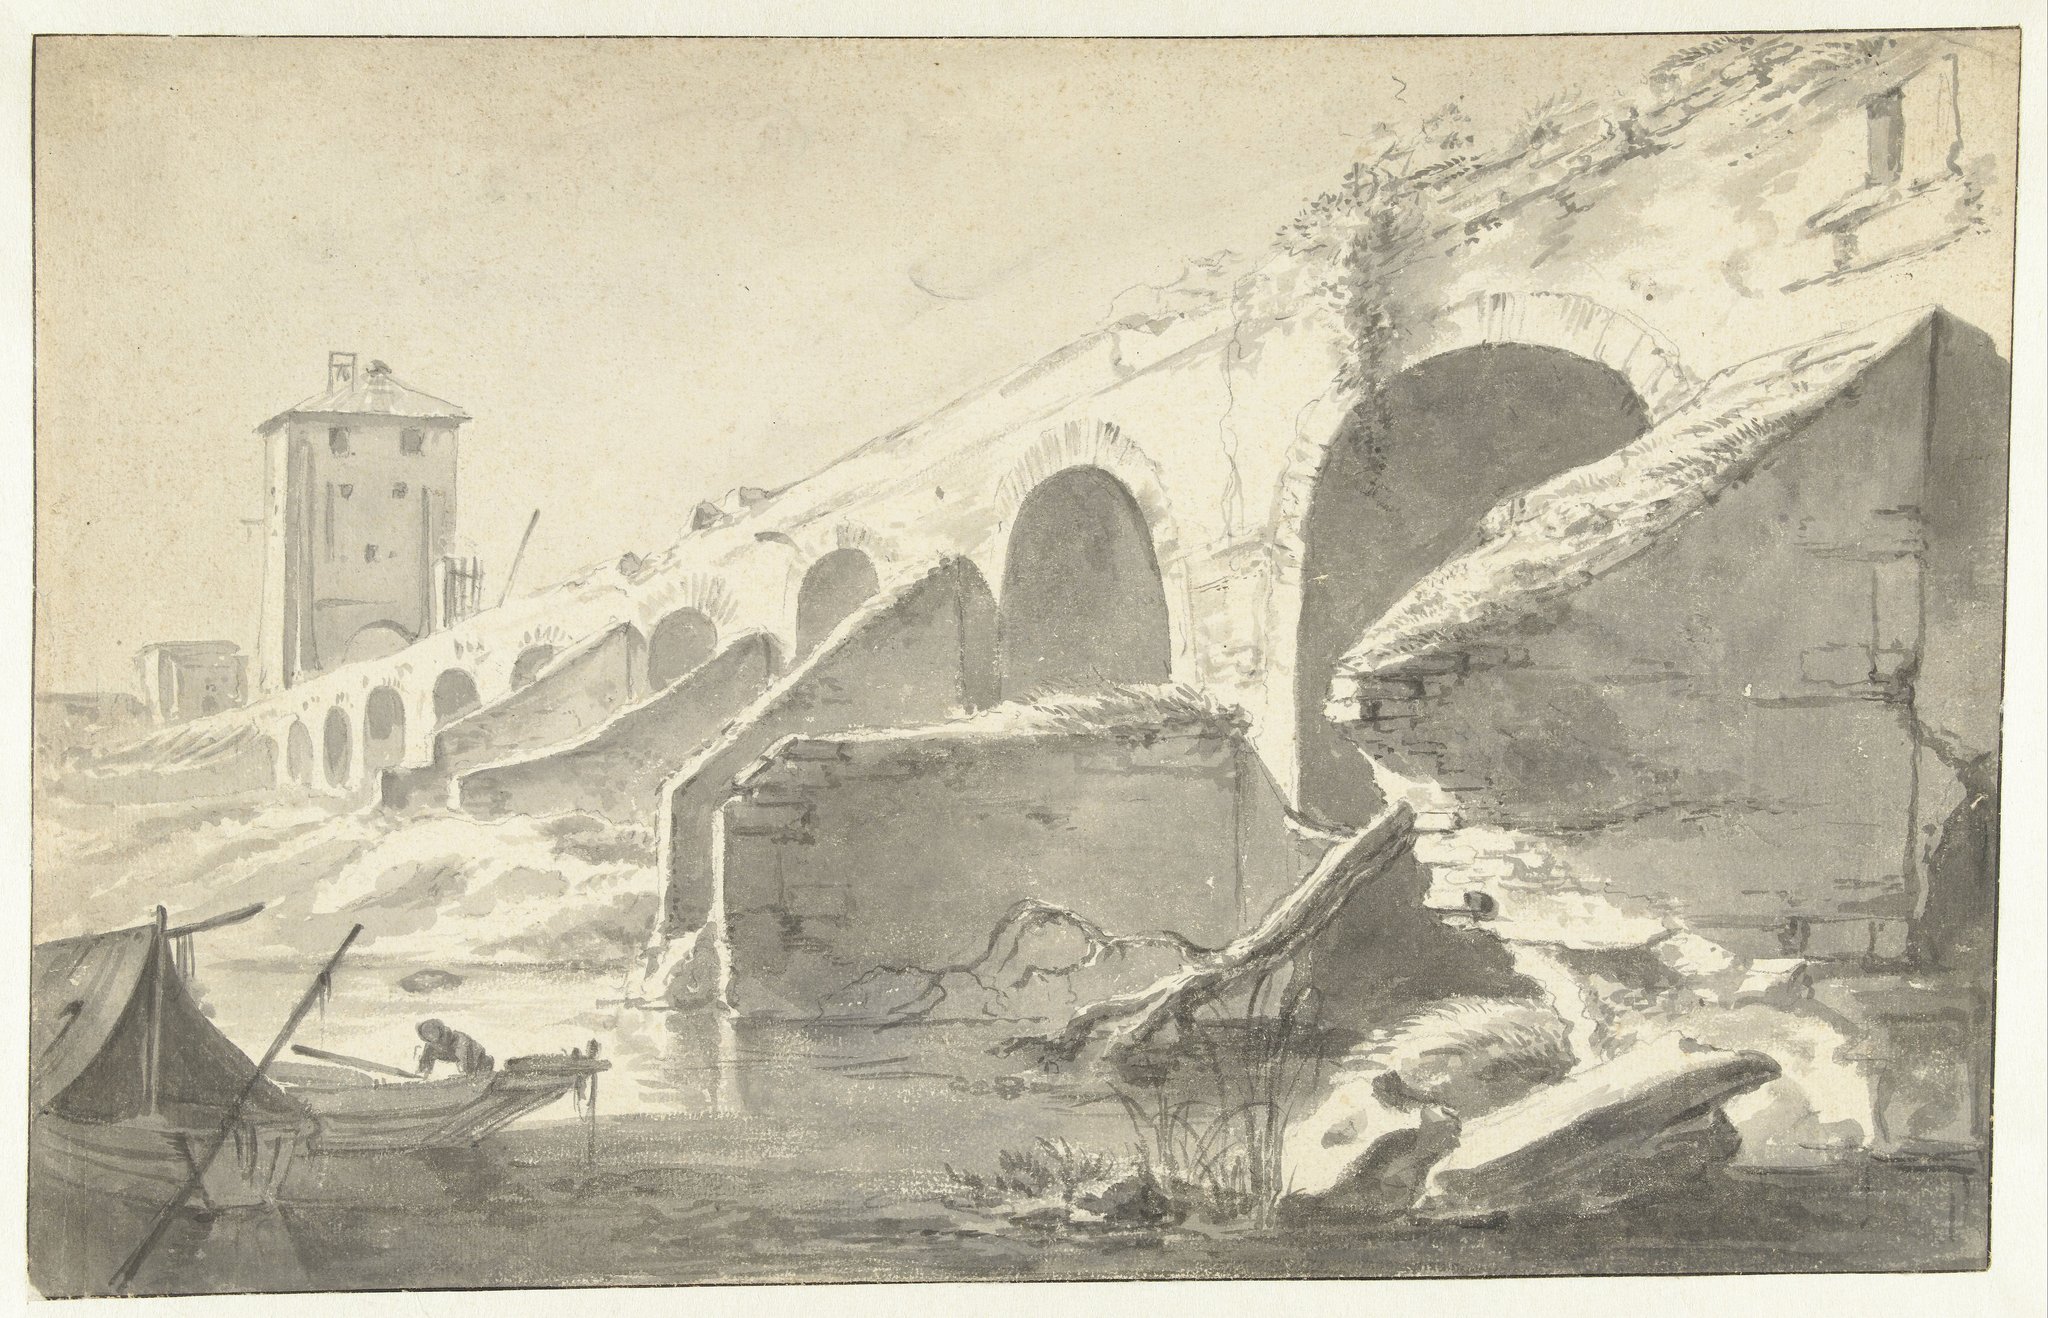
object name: drawing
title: The Pont du Rhône in Lyon seen from the West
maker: willem schellinks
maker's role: draughtsman, painter, print maker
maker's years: 1627-1678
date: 1646-1650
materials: chalk, paper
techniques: brush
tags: rowing-boat, canoe, etc.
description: Lage Romeinse brug over een rivier, door steunberen versterkt; op de voorgrond een man in een roeiboot.